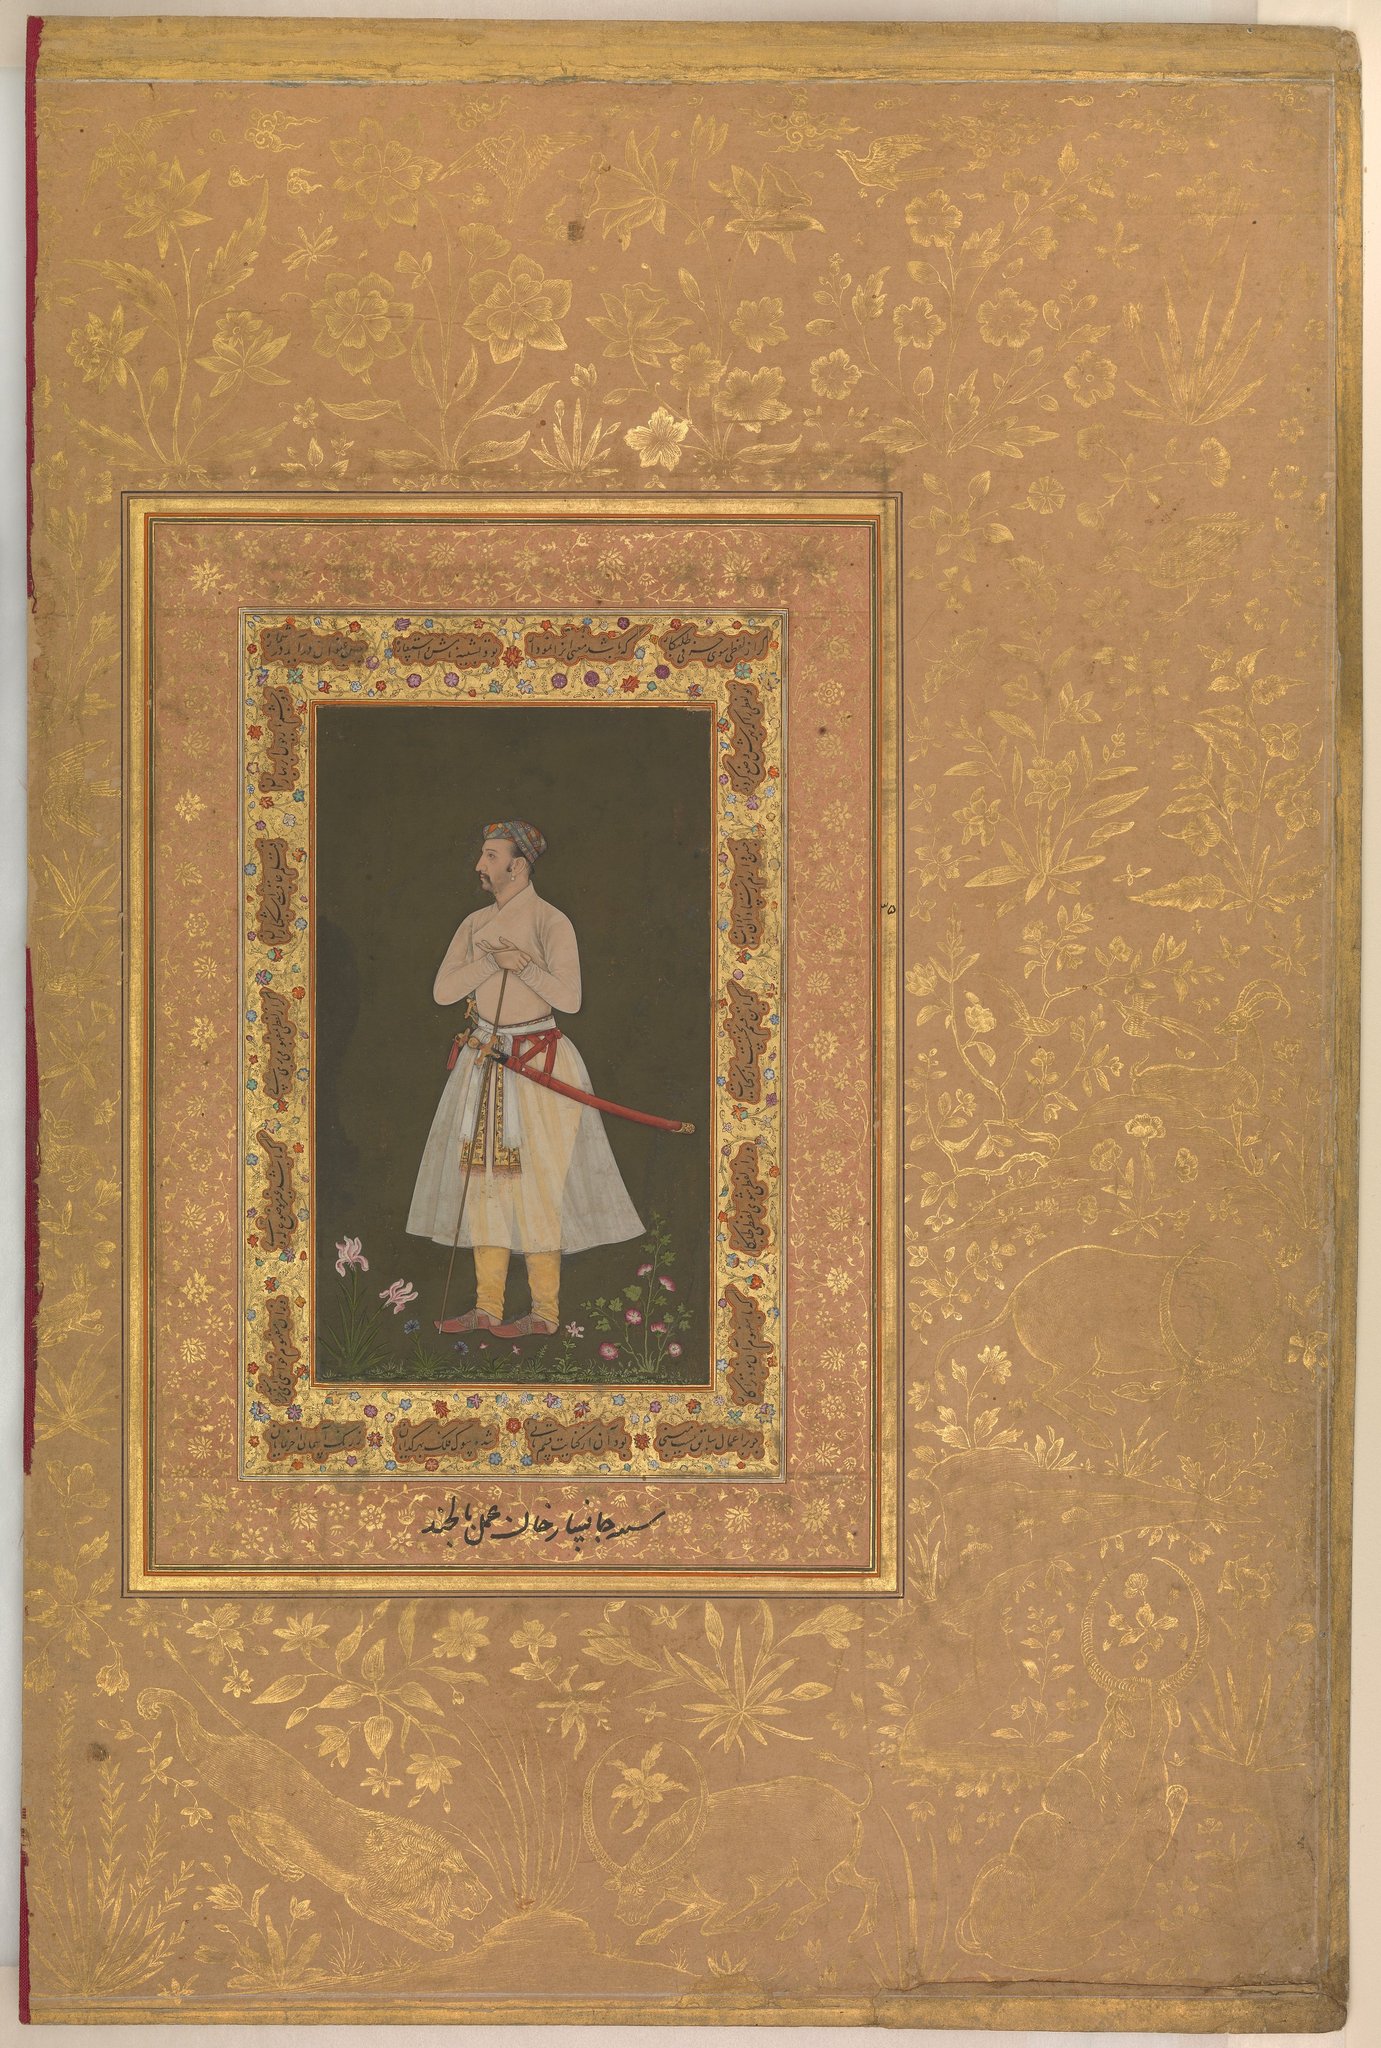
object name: album leaf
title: "Portrait of Jahangir Beg, Jansipar Khan", Folio from the Shah Jahan Album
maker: balchand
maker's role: artist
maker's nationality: indian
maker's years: 1595-1650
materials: gold, ink, paper, watercolor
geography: india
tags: men,profiles,flowers